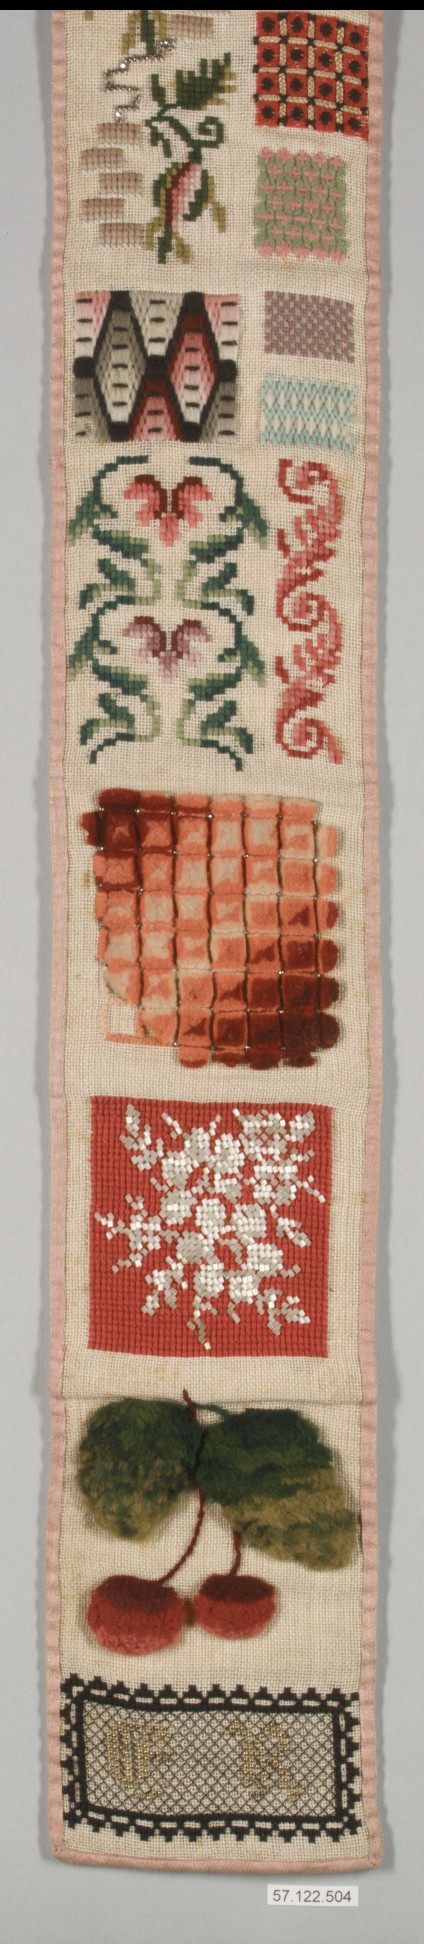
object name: sampler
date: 1801-1900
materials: canvas, wool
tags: cherries